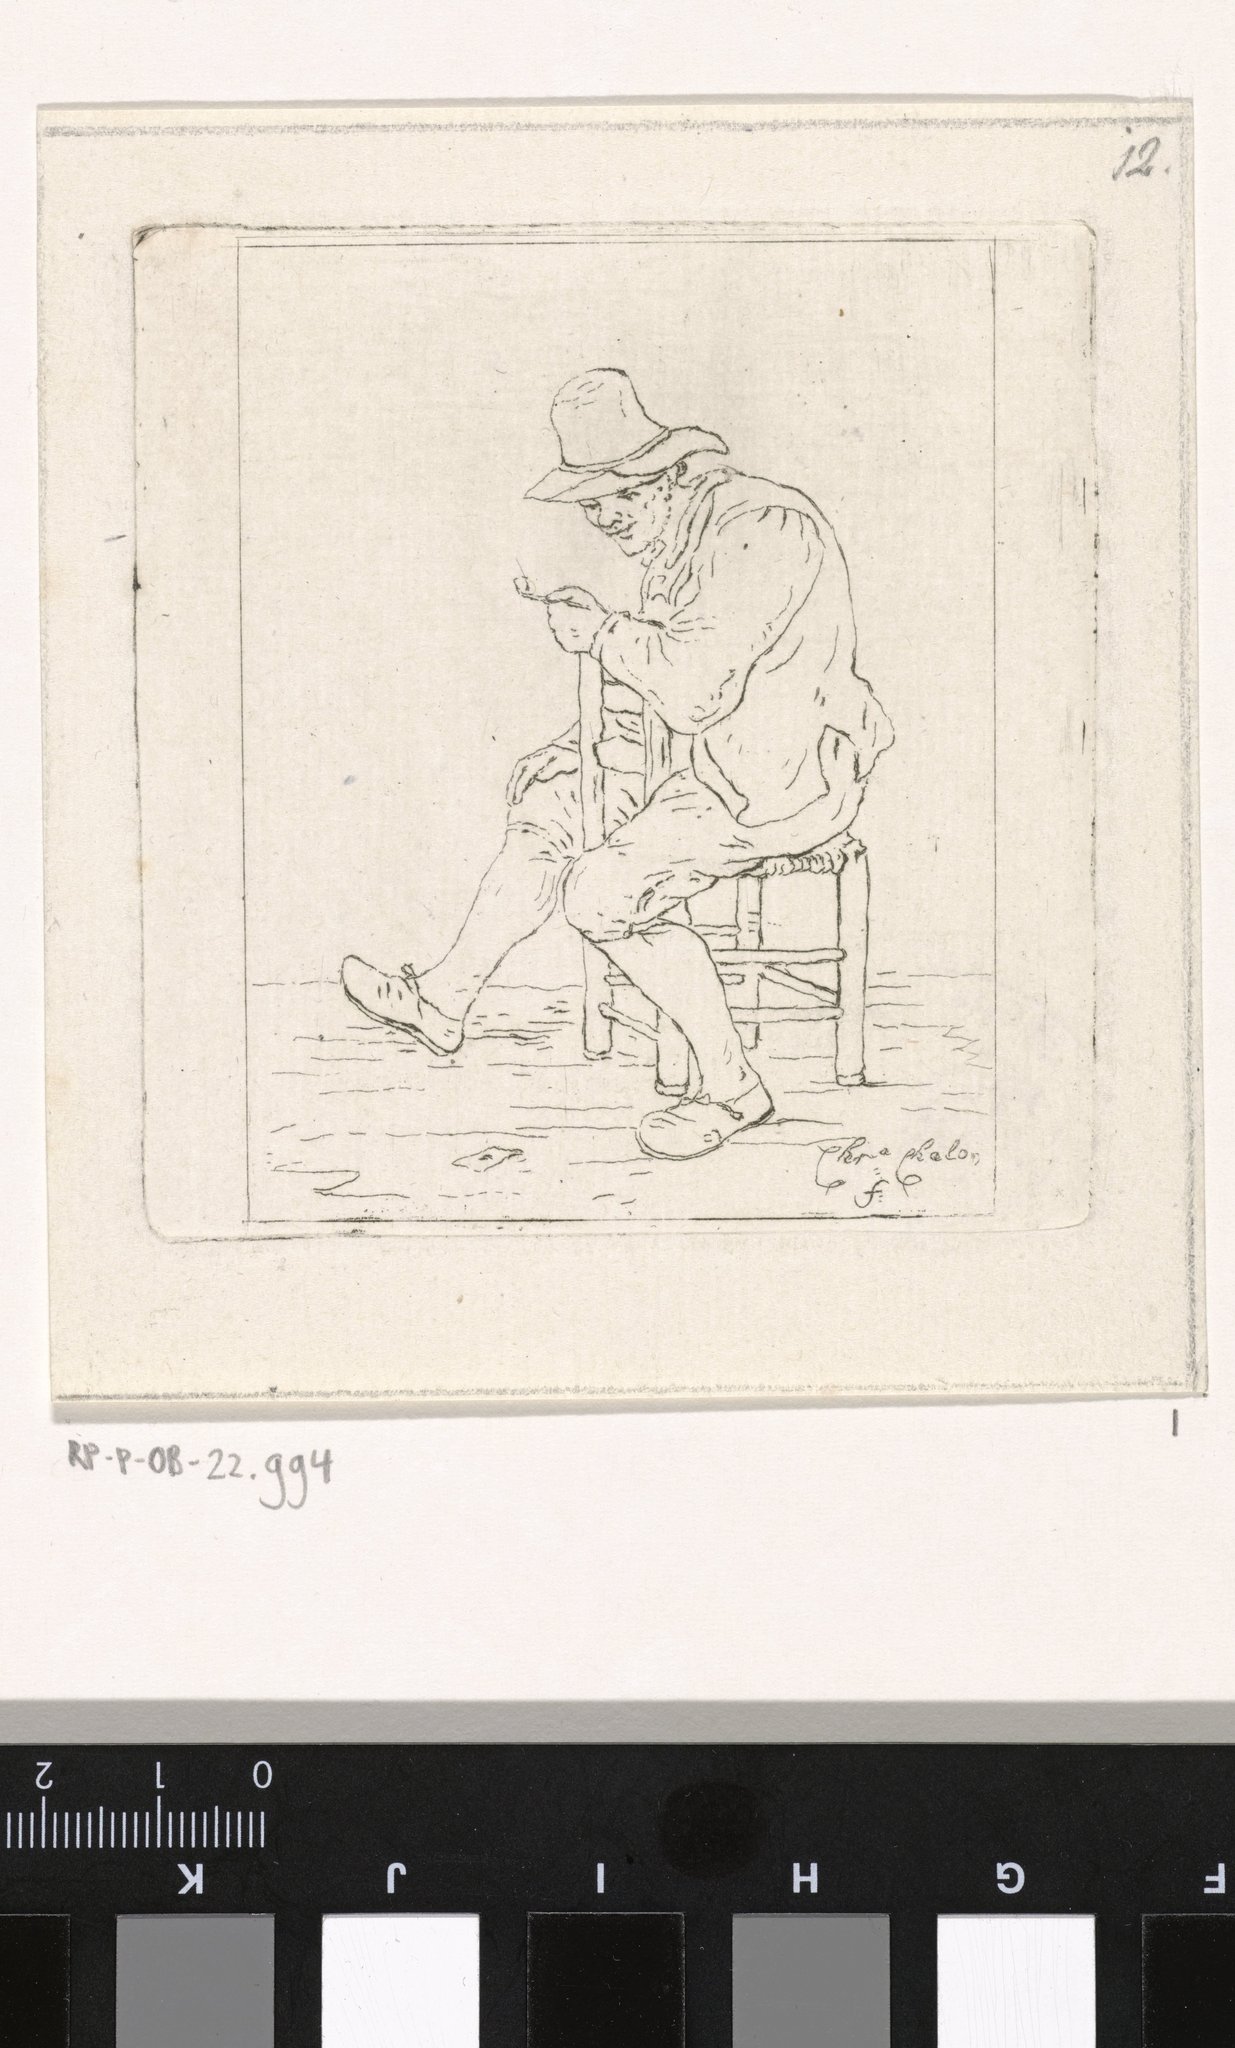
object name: print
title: Rokende boer met pijp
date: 1779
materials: paper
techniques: etching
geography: leiden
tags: pipe ~ tobacco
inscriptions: collector's mark: Lugt 240, number: ‘12’